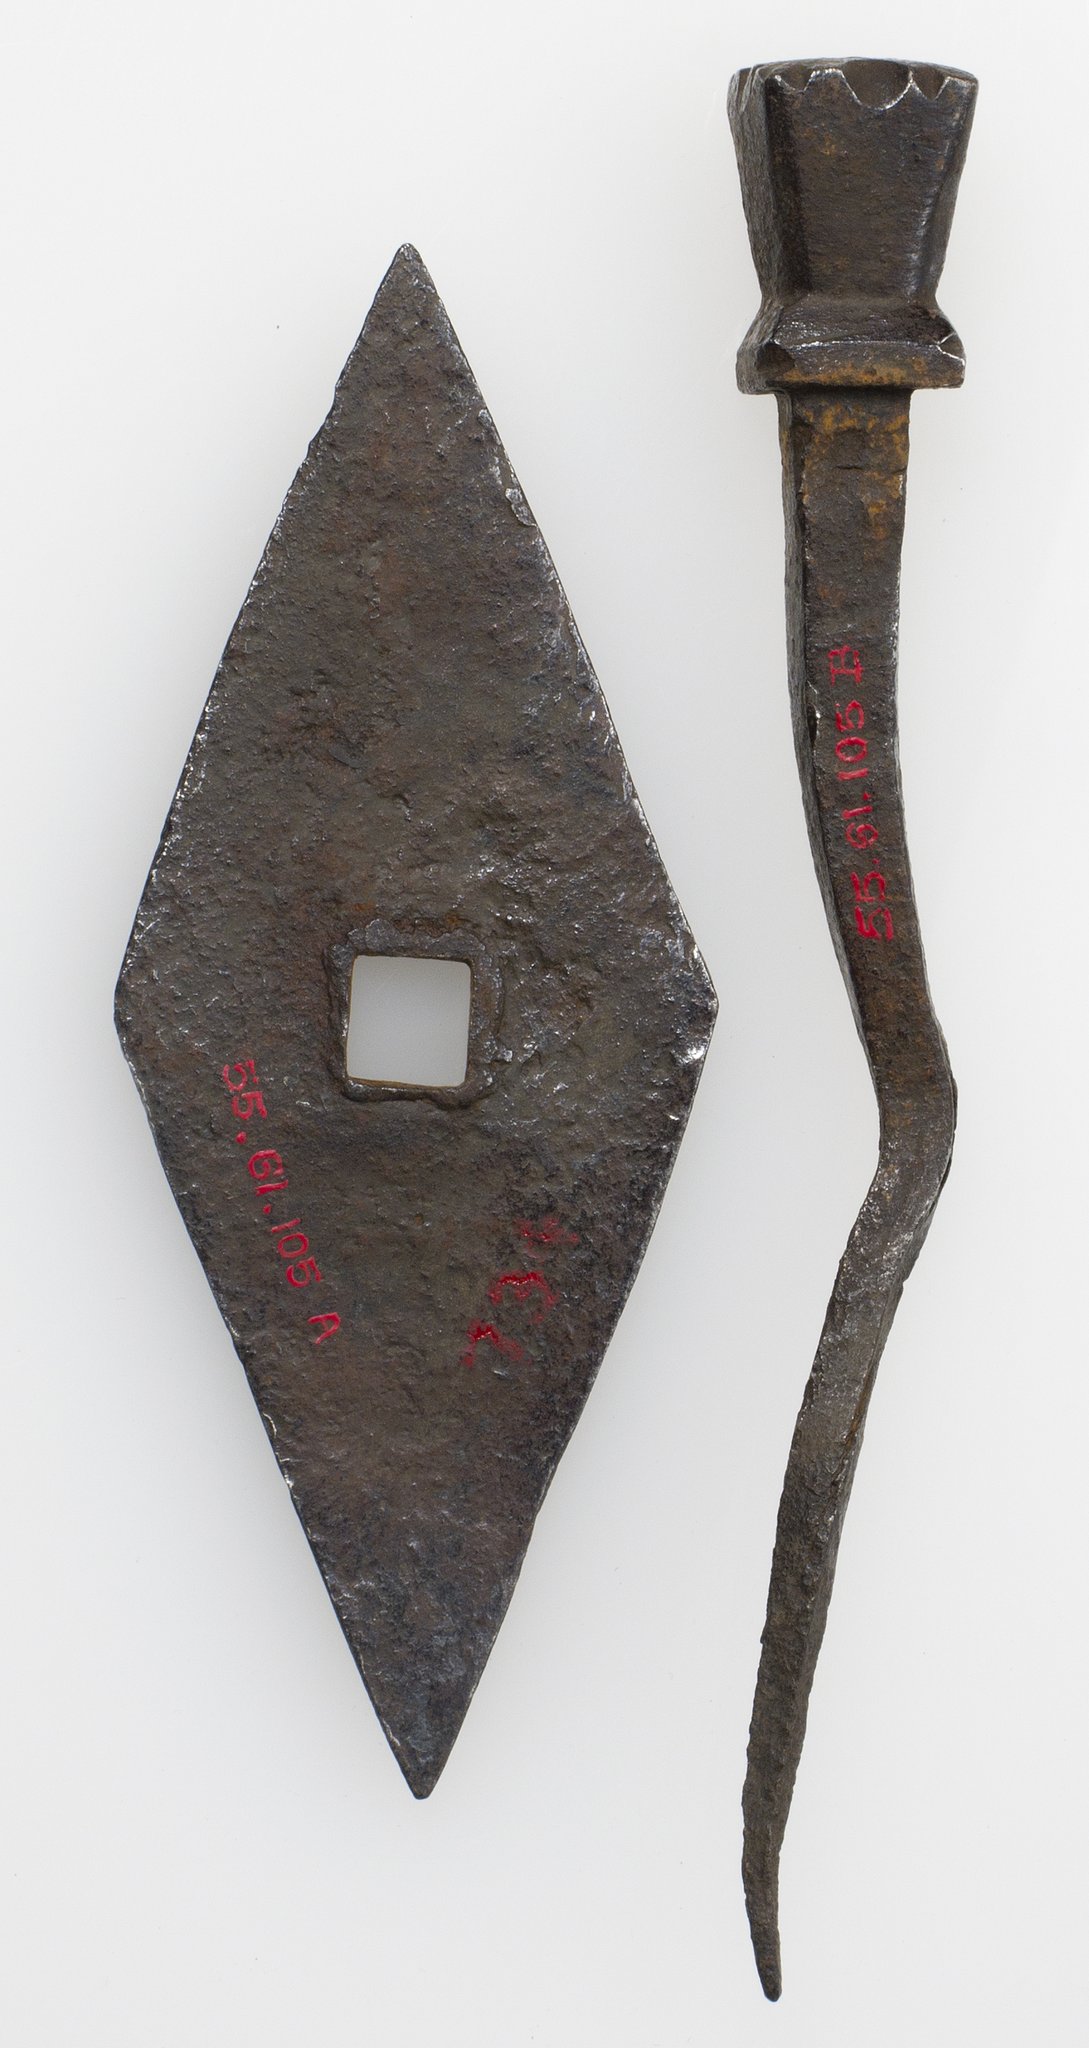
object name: plate and nail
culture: european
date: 1401-1600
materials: iron